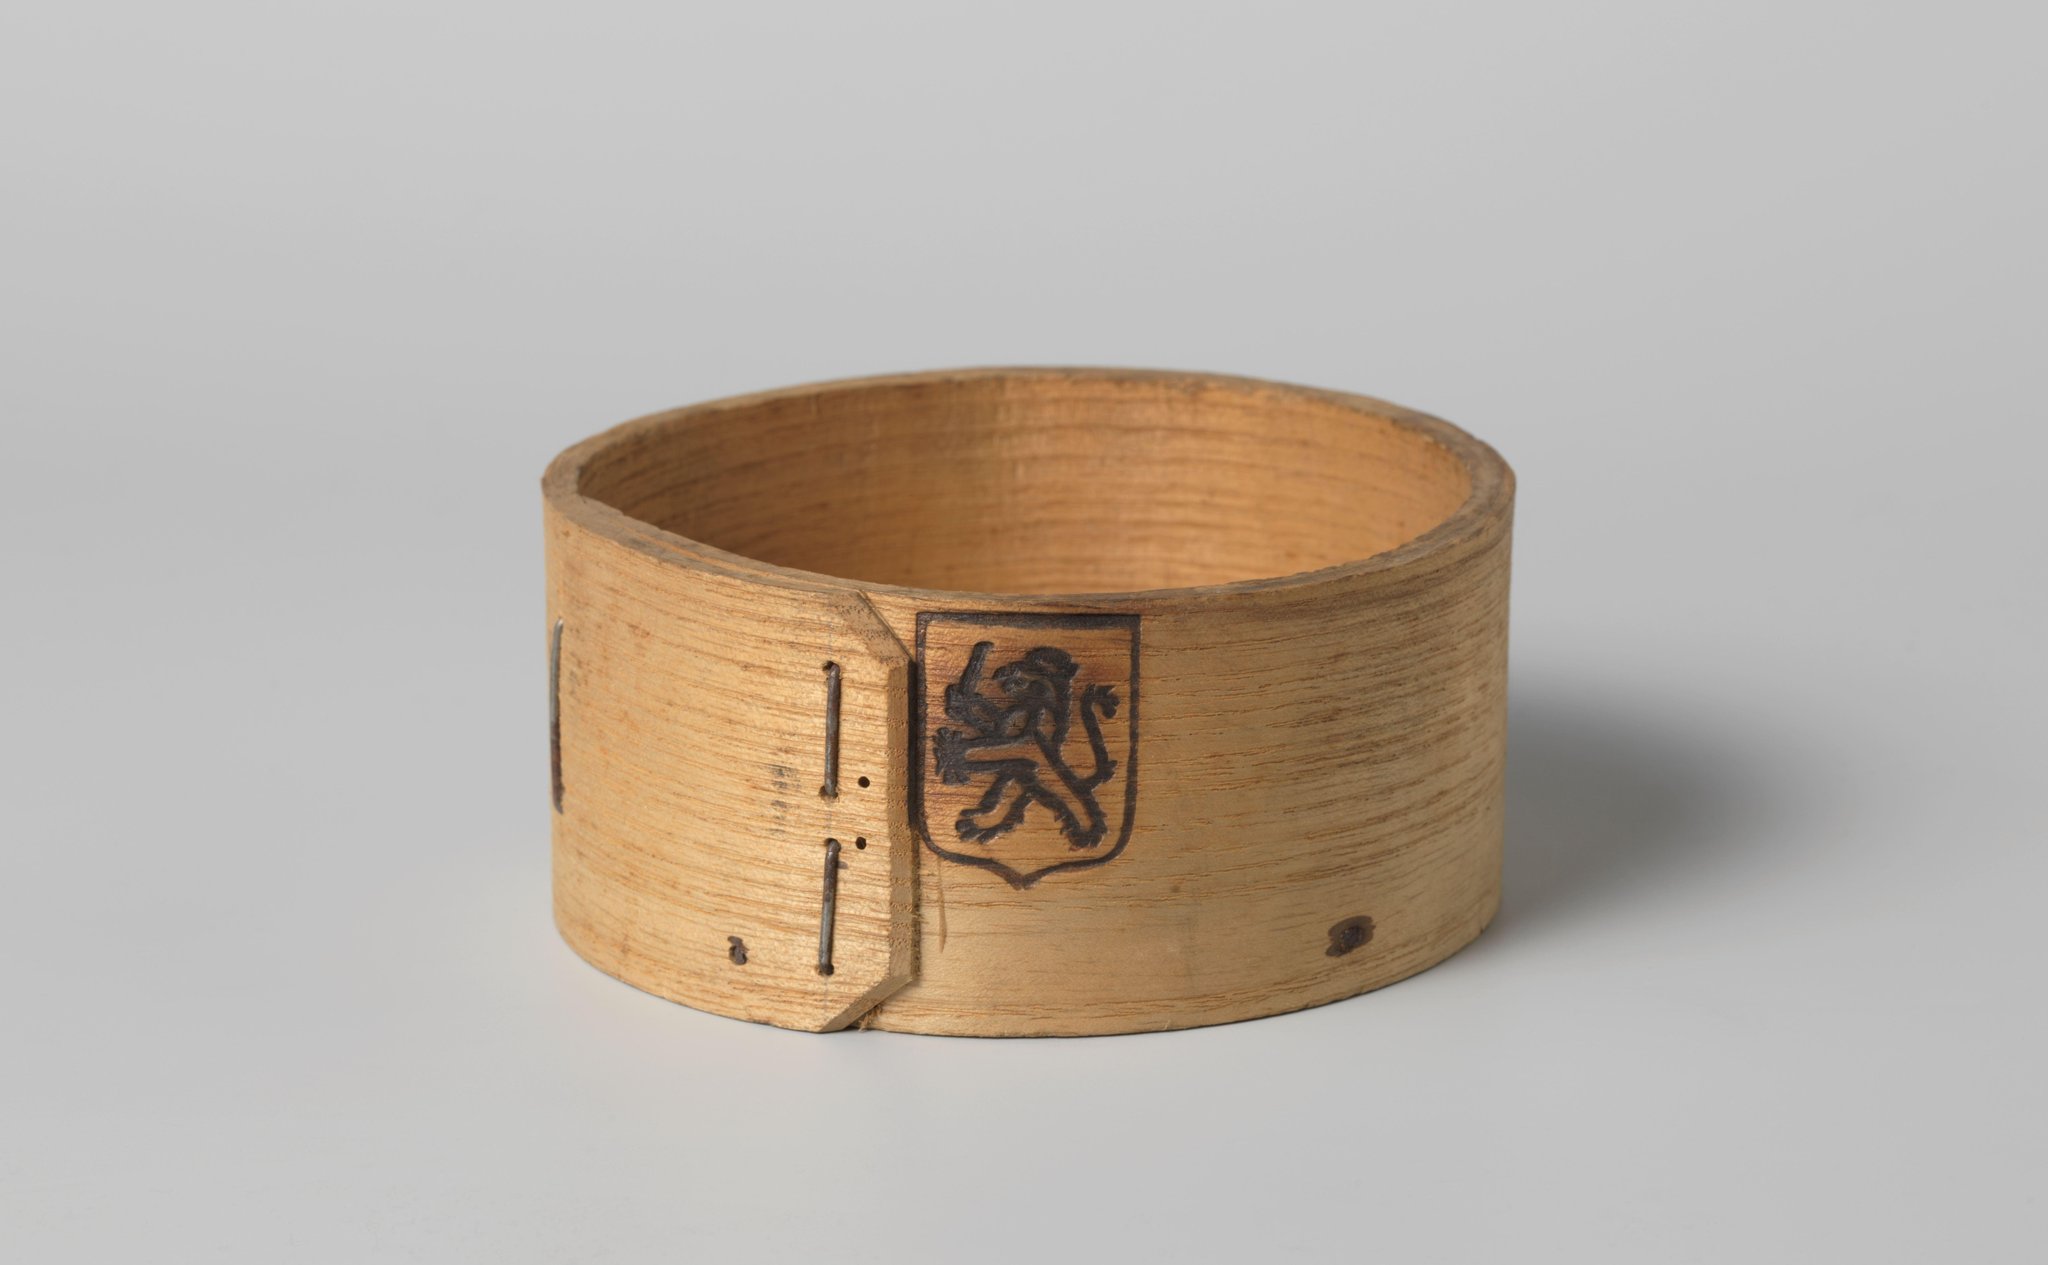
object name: graanmaat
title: Houten graanmaat.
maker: Anonymous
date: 1650-1823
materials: metal, wood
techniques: printing, metalworking, nailed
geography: netherlands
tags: netherlands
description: Houten rond object met vlakke bodem. De buitenzijde is over elkaar gelegd en gekramd. Op de buitenzijde, naast de naad, is het stempel (staande leeuw) aangebracht. De bodem is met nagels in het object gemonteerd.